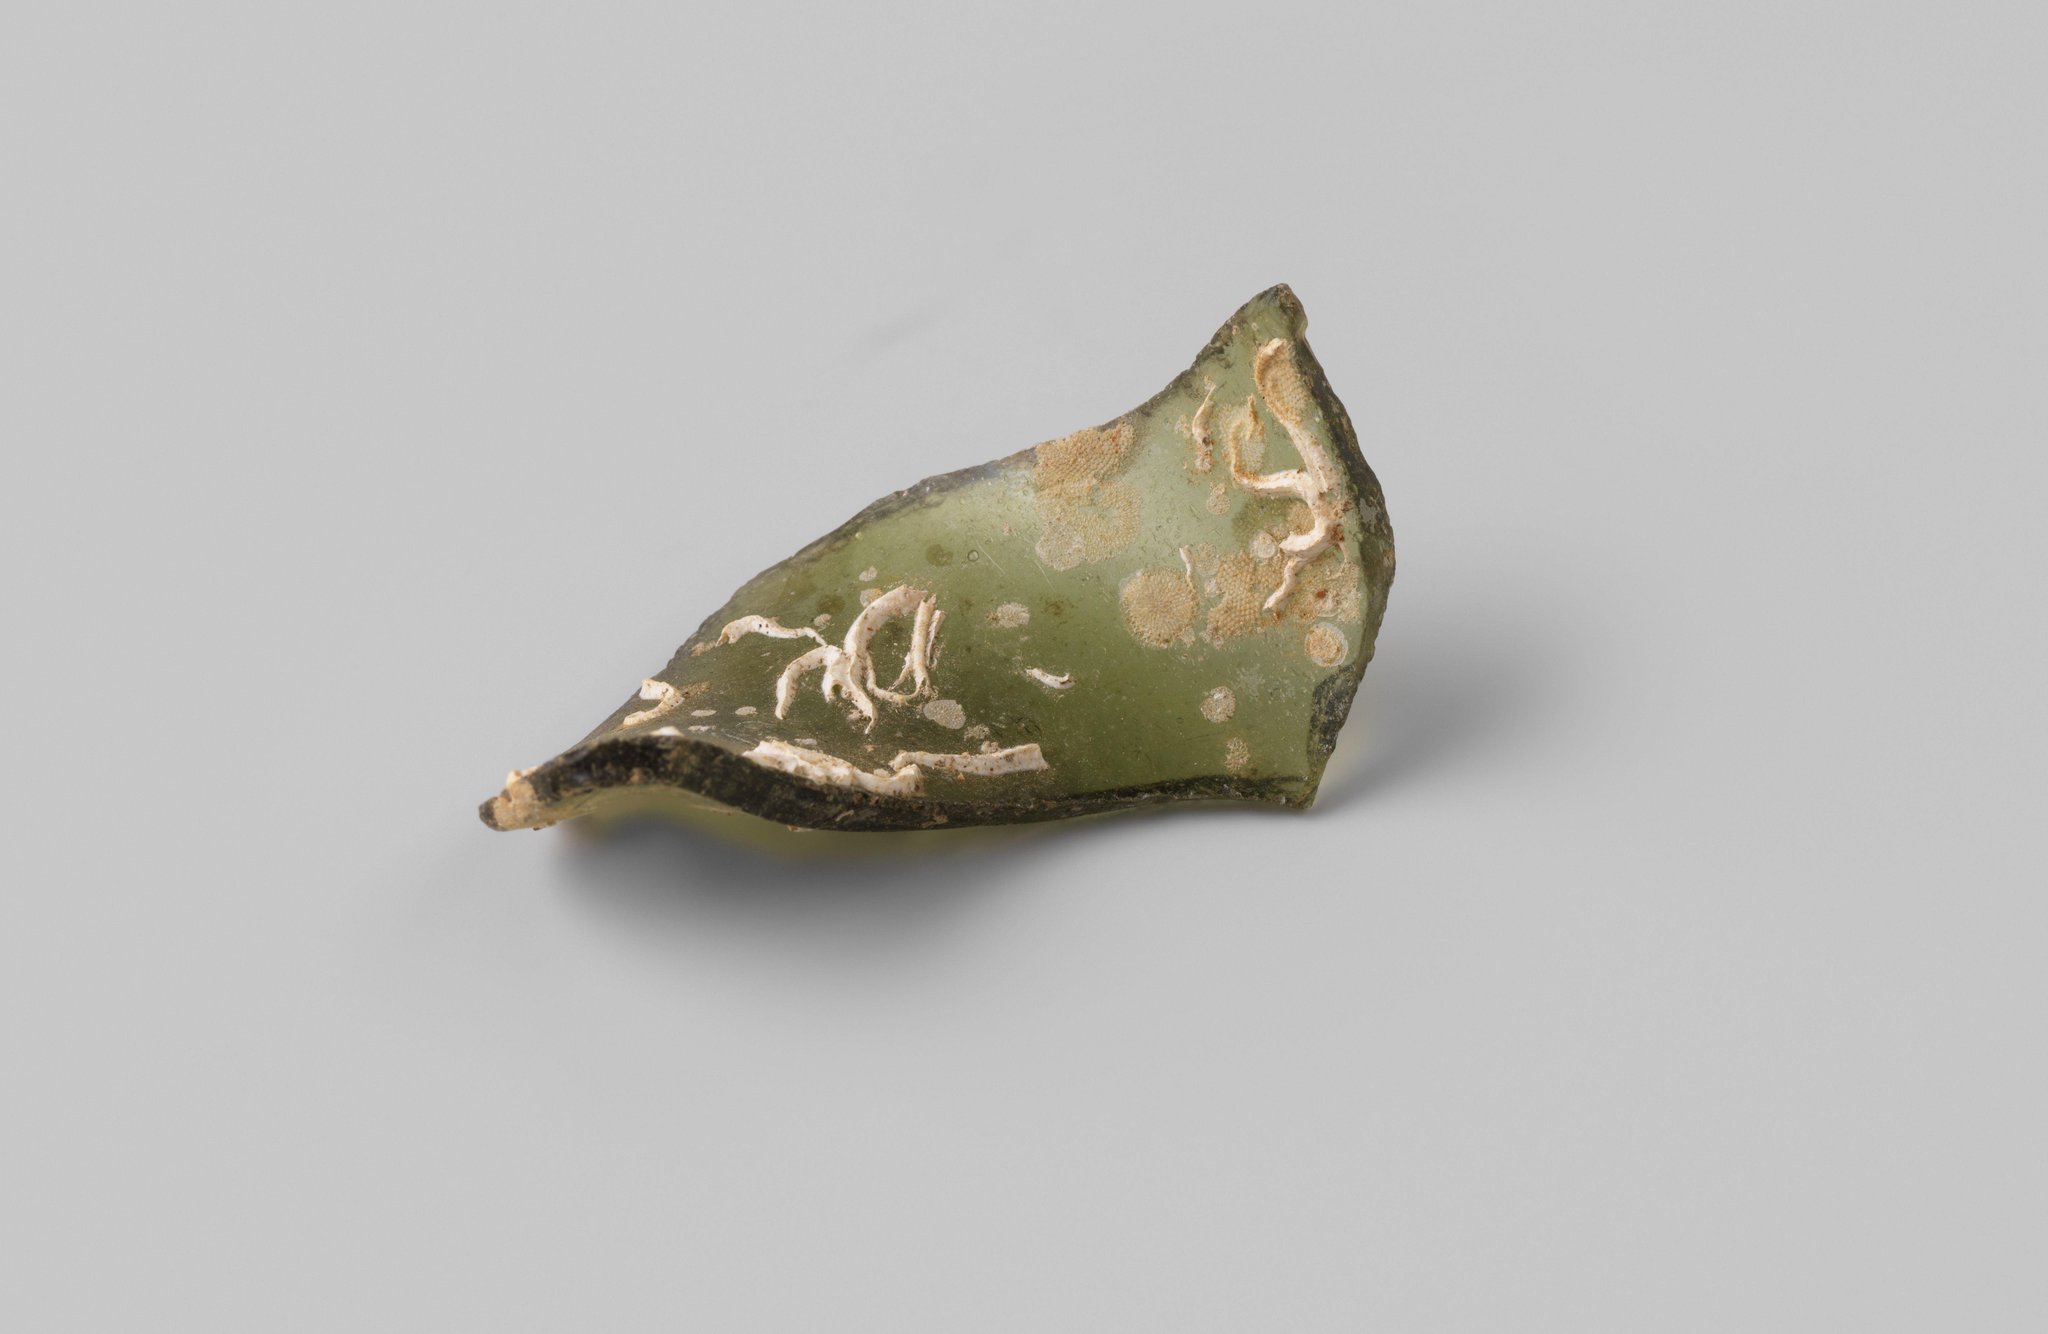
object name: wine bottle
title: Scherf van een wijnfles uit het wrak van de Oost-Indiëvaarder Hollandia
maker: Anonymous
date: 1700-1743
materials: glass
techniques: green glass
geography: netherlands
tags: verenigde oostindische compagnie, hollandia (schip), annet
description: Typologically not identifiable, shoulder, fragm.